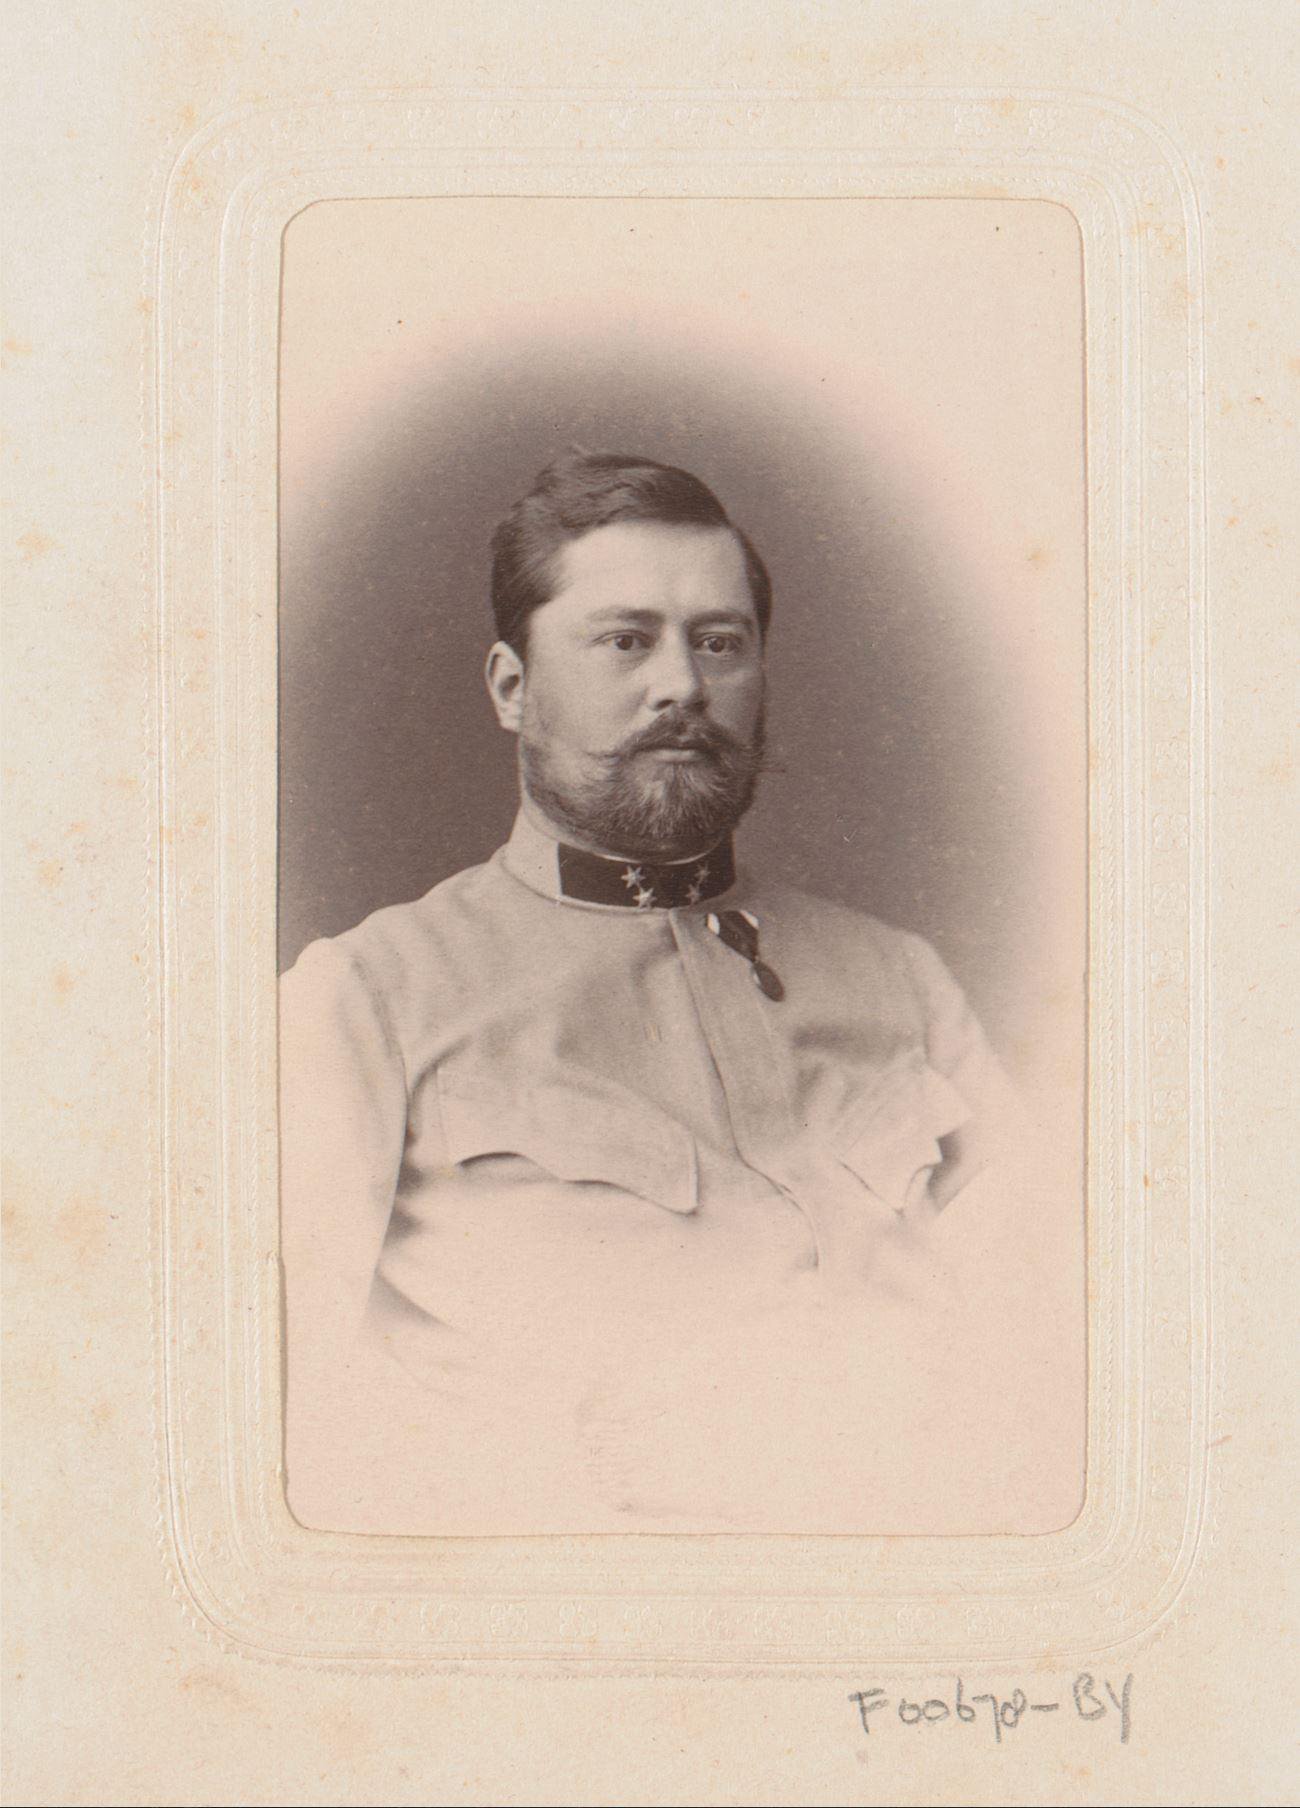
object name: album leaf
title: Portret van een zittende man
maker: g. haslinger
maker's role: fotograaf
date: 1873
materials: cardboard, photographic support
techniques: albumen print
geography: sankt pölten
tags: historical persons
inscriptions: inscription: ‘G. Haslinger/ fotograf in St. Pölten/ Guttmanns Bierhalle’, annotation: ‘Viktor [...]/ [...]/ 7. 1873’